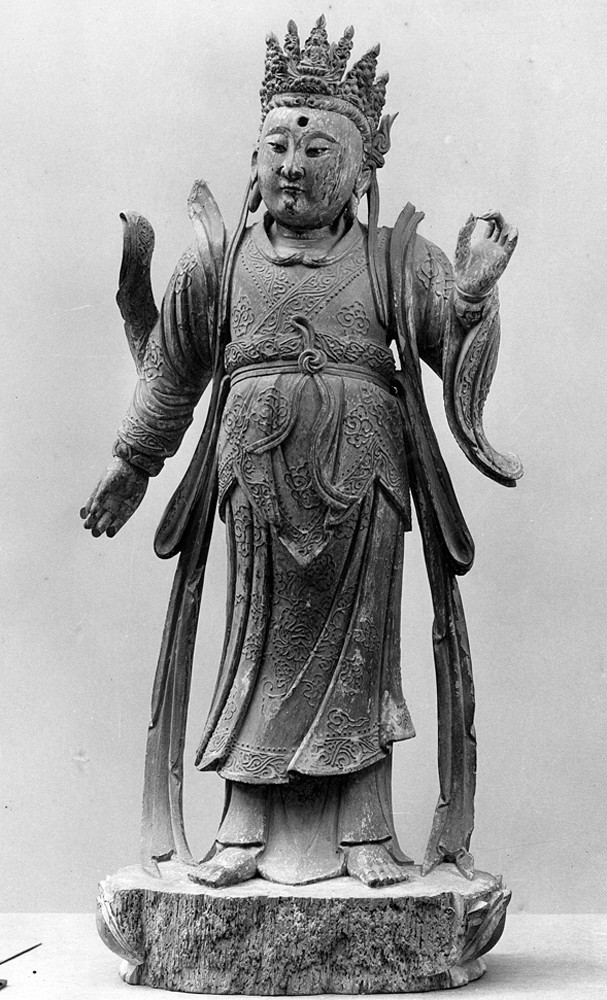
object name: figure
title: Statue of Guanyin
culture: chinese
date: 1368-1644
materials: wood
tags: bodhisattvas